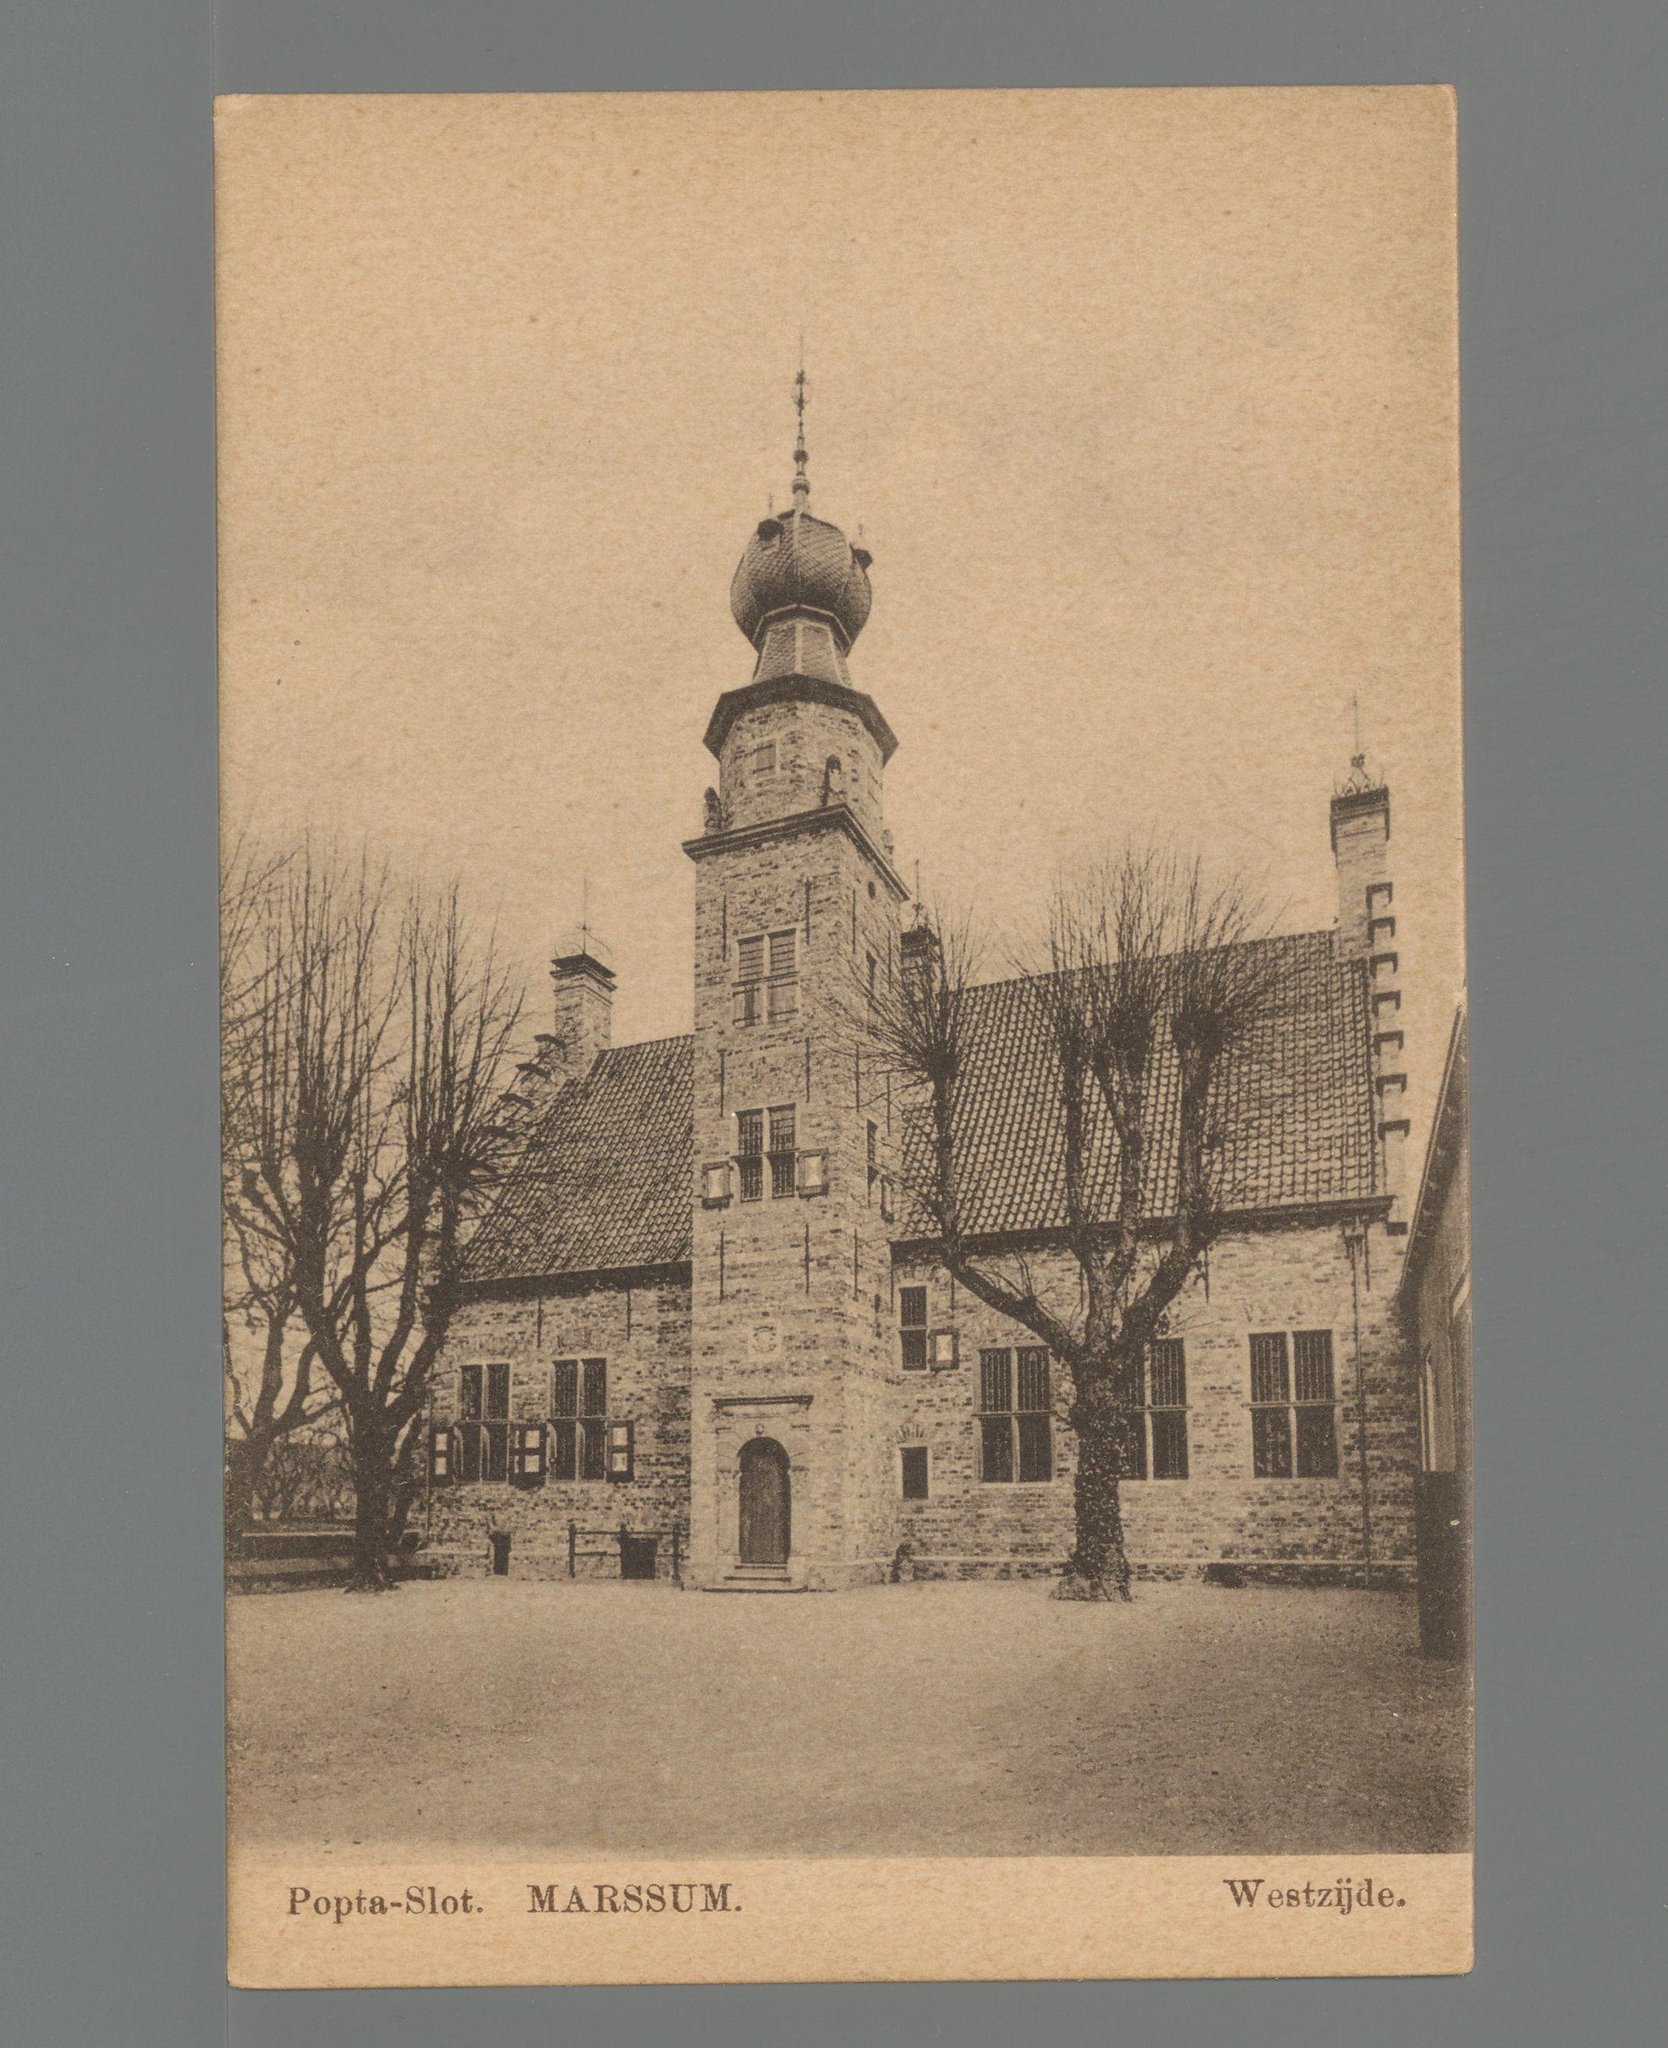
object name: photomechanical print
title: Popta-Slot. Marssum. Westzijde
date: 1905-1927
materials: cardboard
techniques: photograph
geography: leeuwarden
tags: castle, permanent exhibition, museum